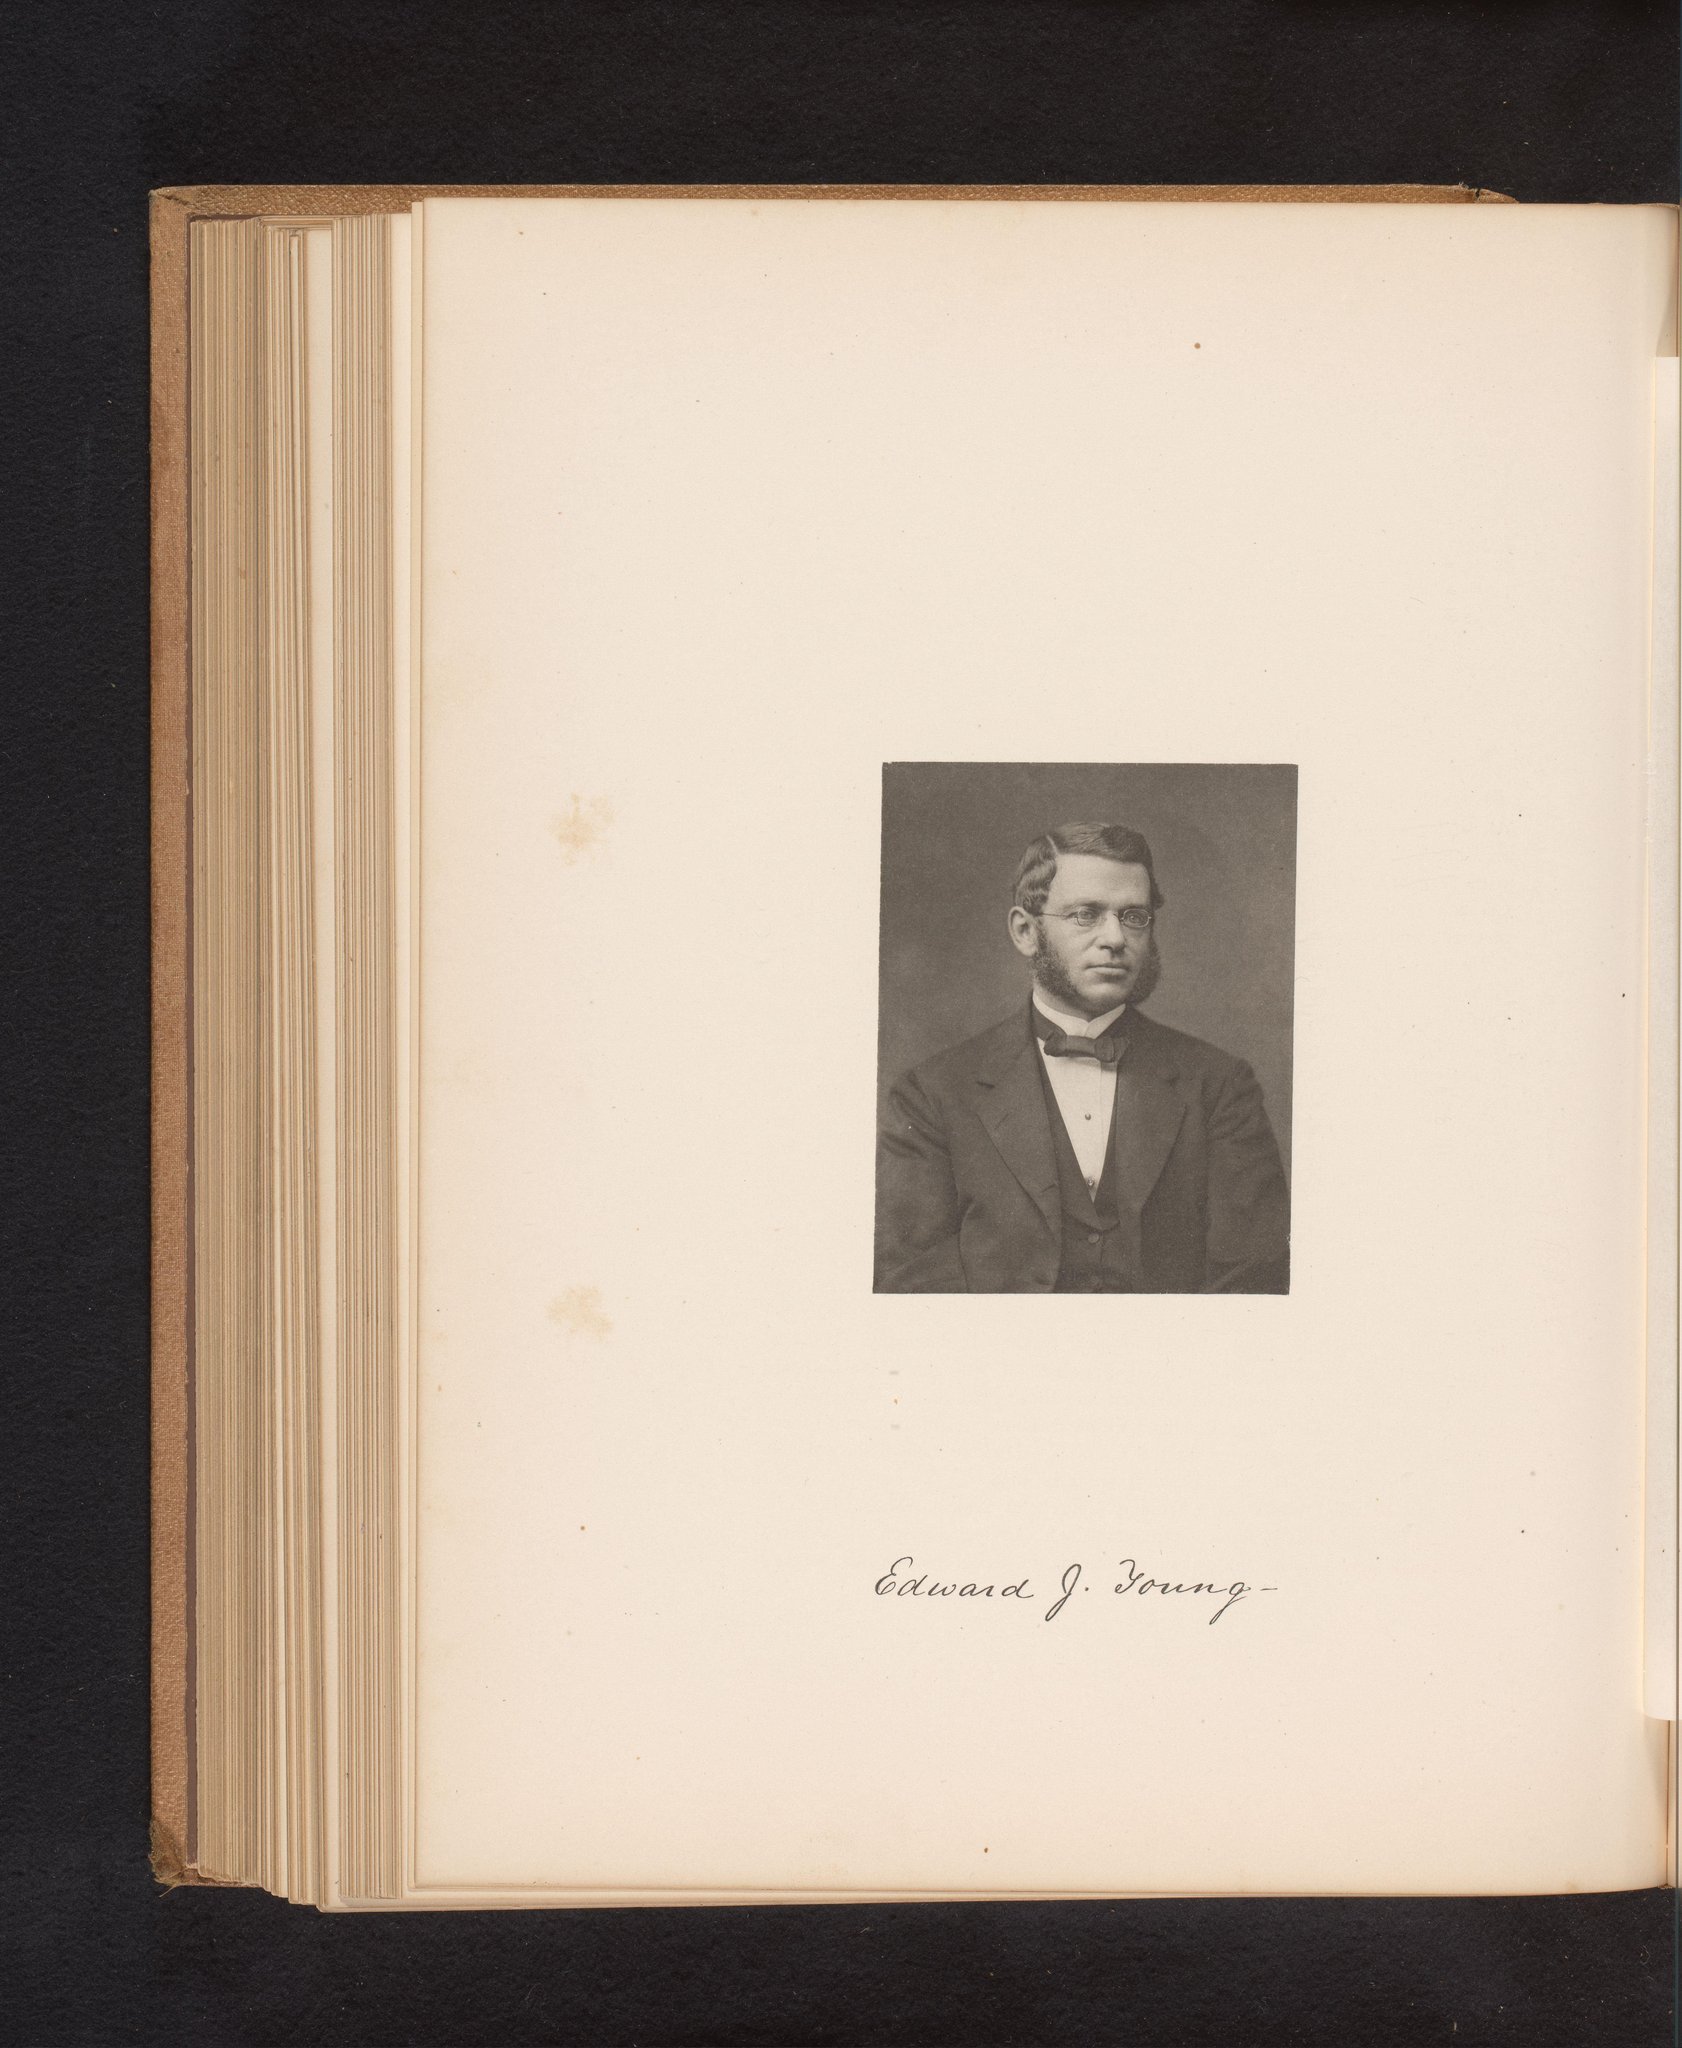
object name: photomechanical print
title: Edward J. Young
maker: Anonymous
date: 1870-1875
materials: paper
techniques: photograph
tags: historical persons, writer, poet, author